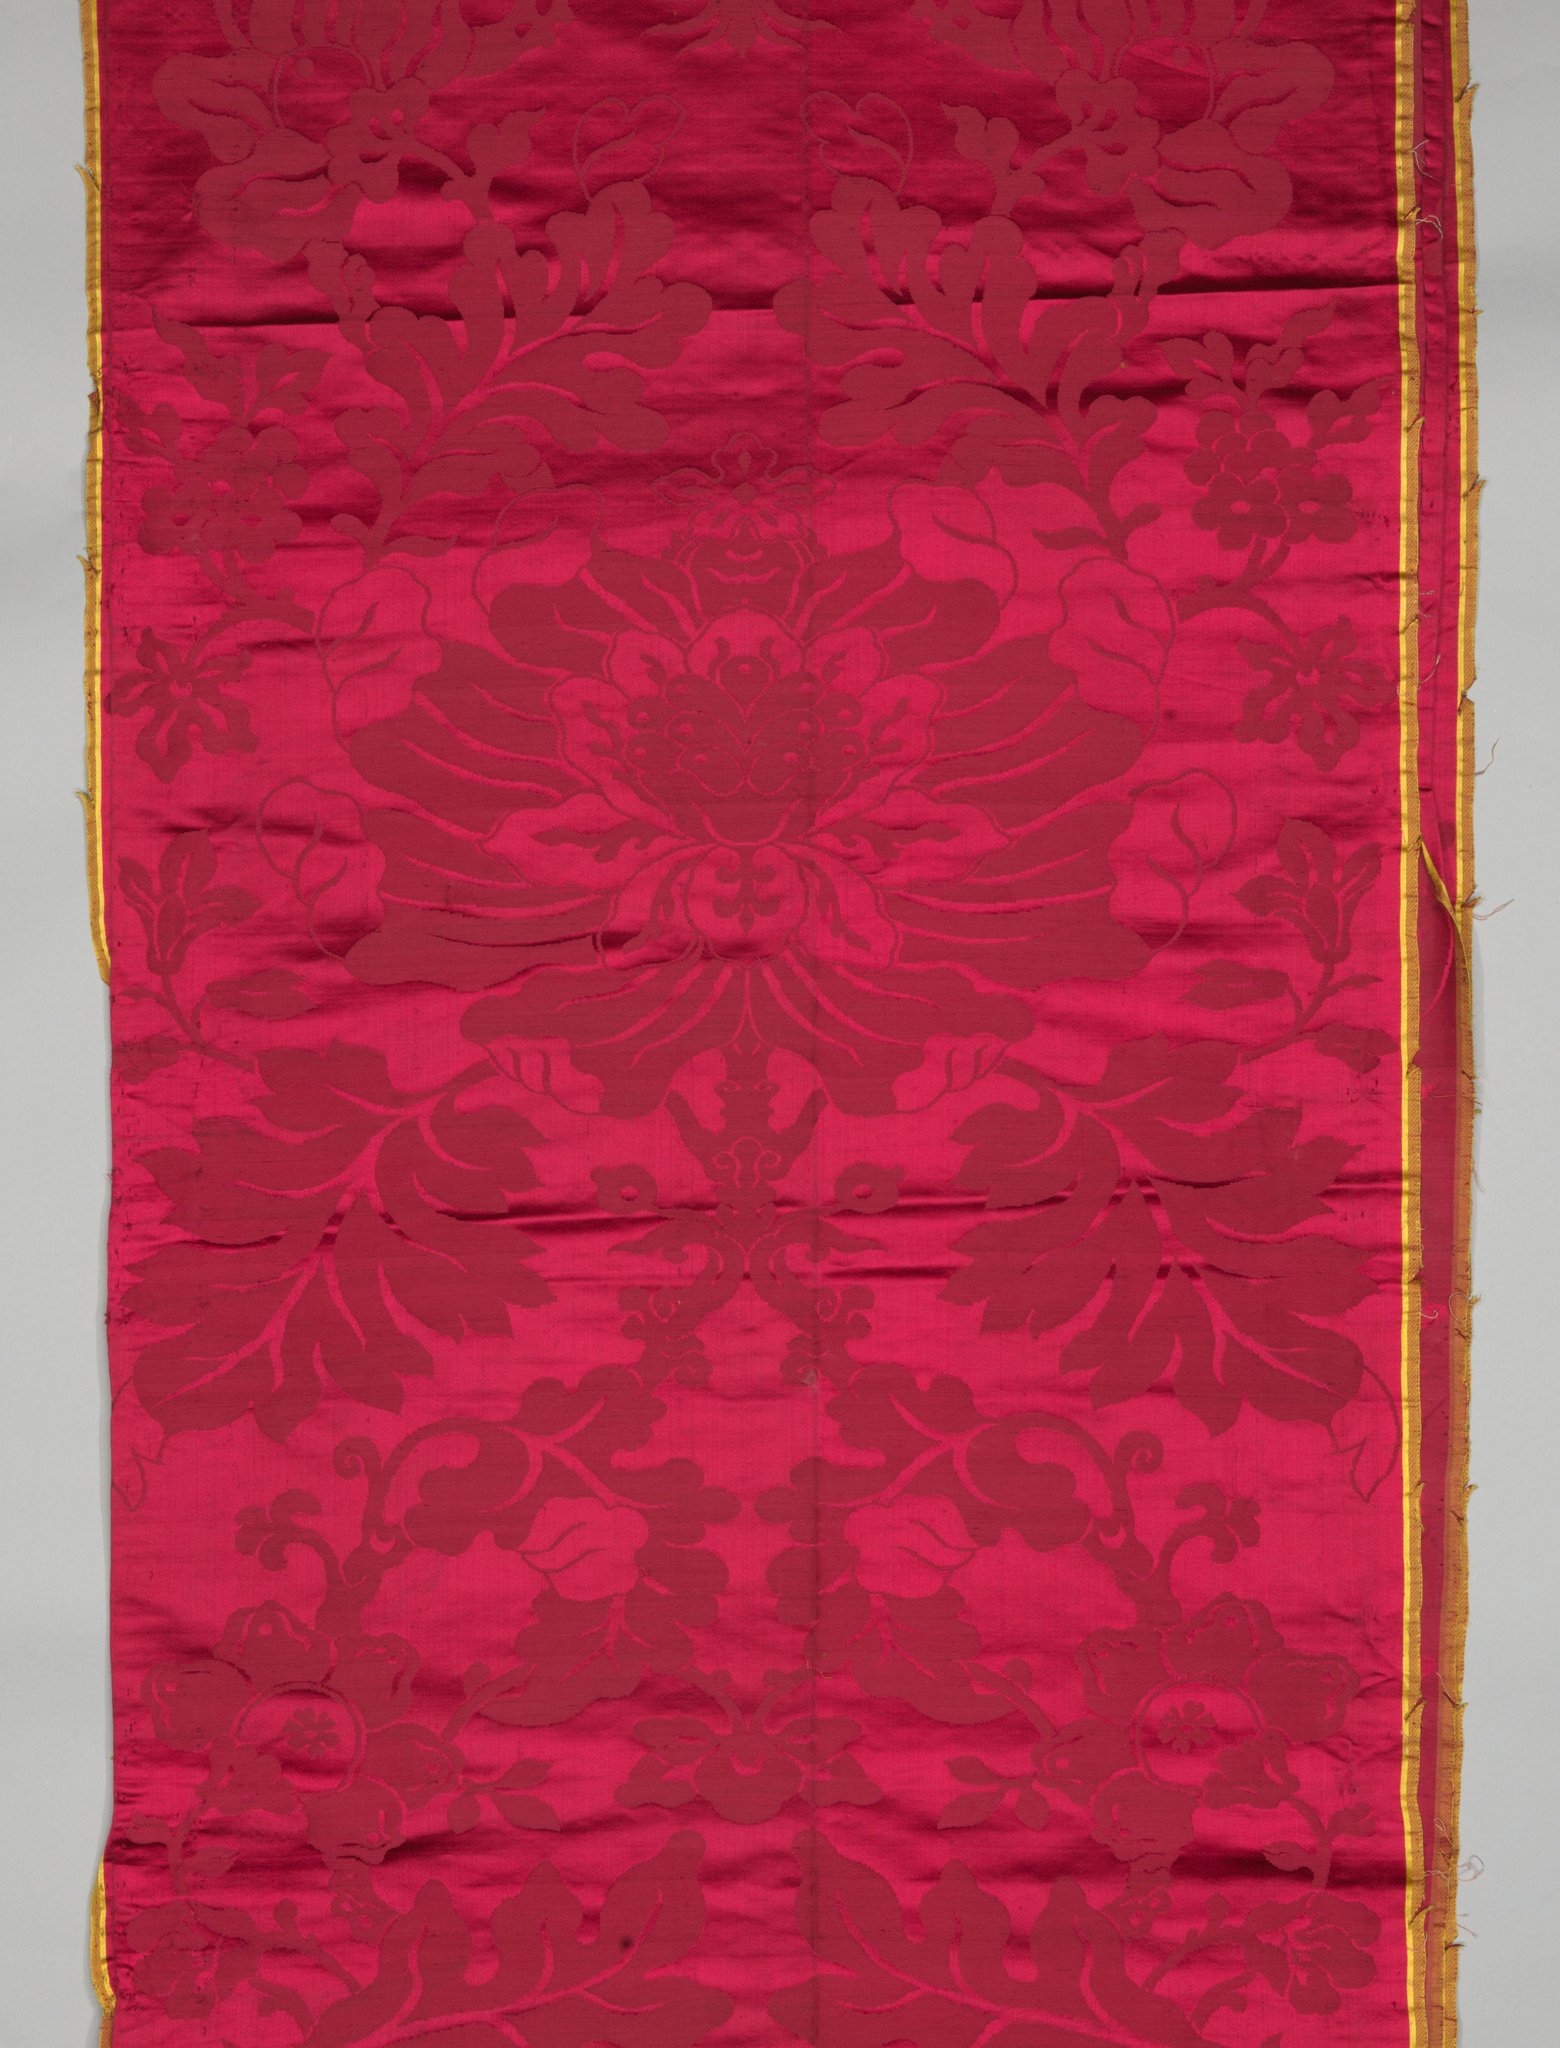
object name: fragment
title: Fragment van rood zijdedamast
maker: Anonymous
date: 1830-1870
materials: silk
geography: china